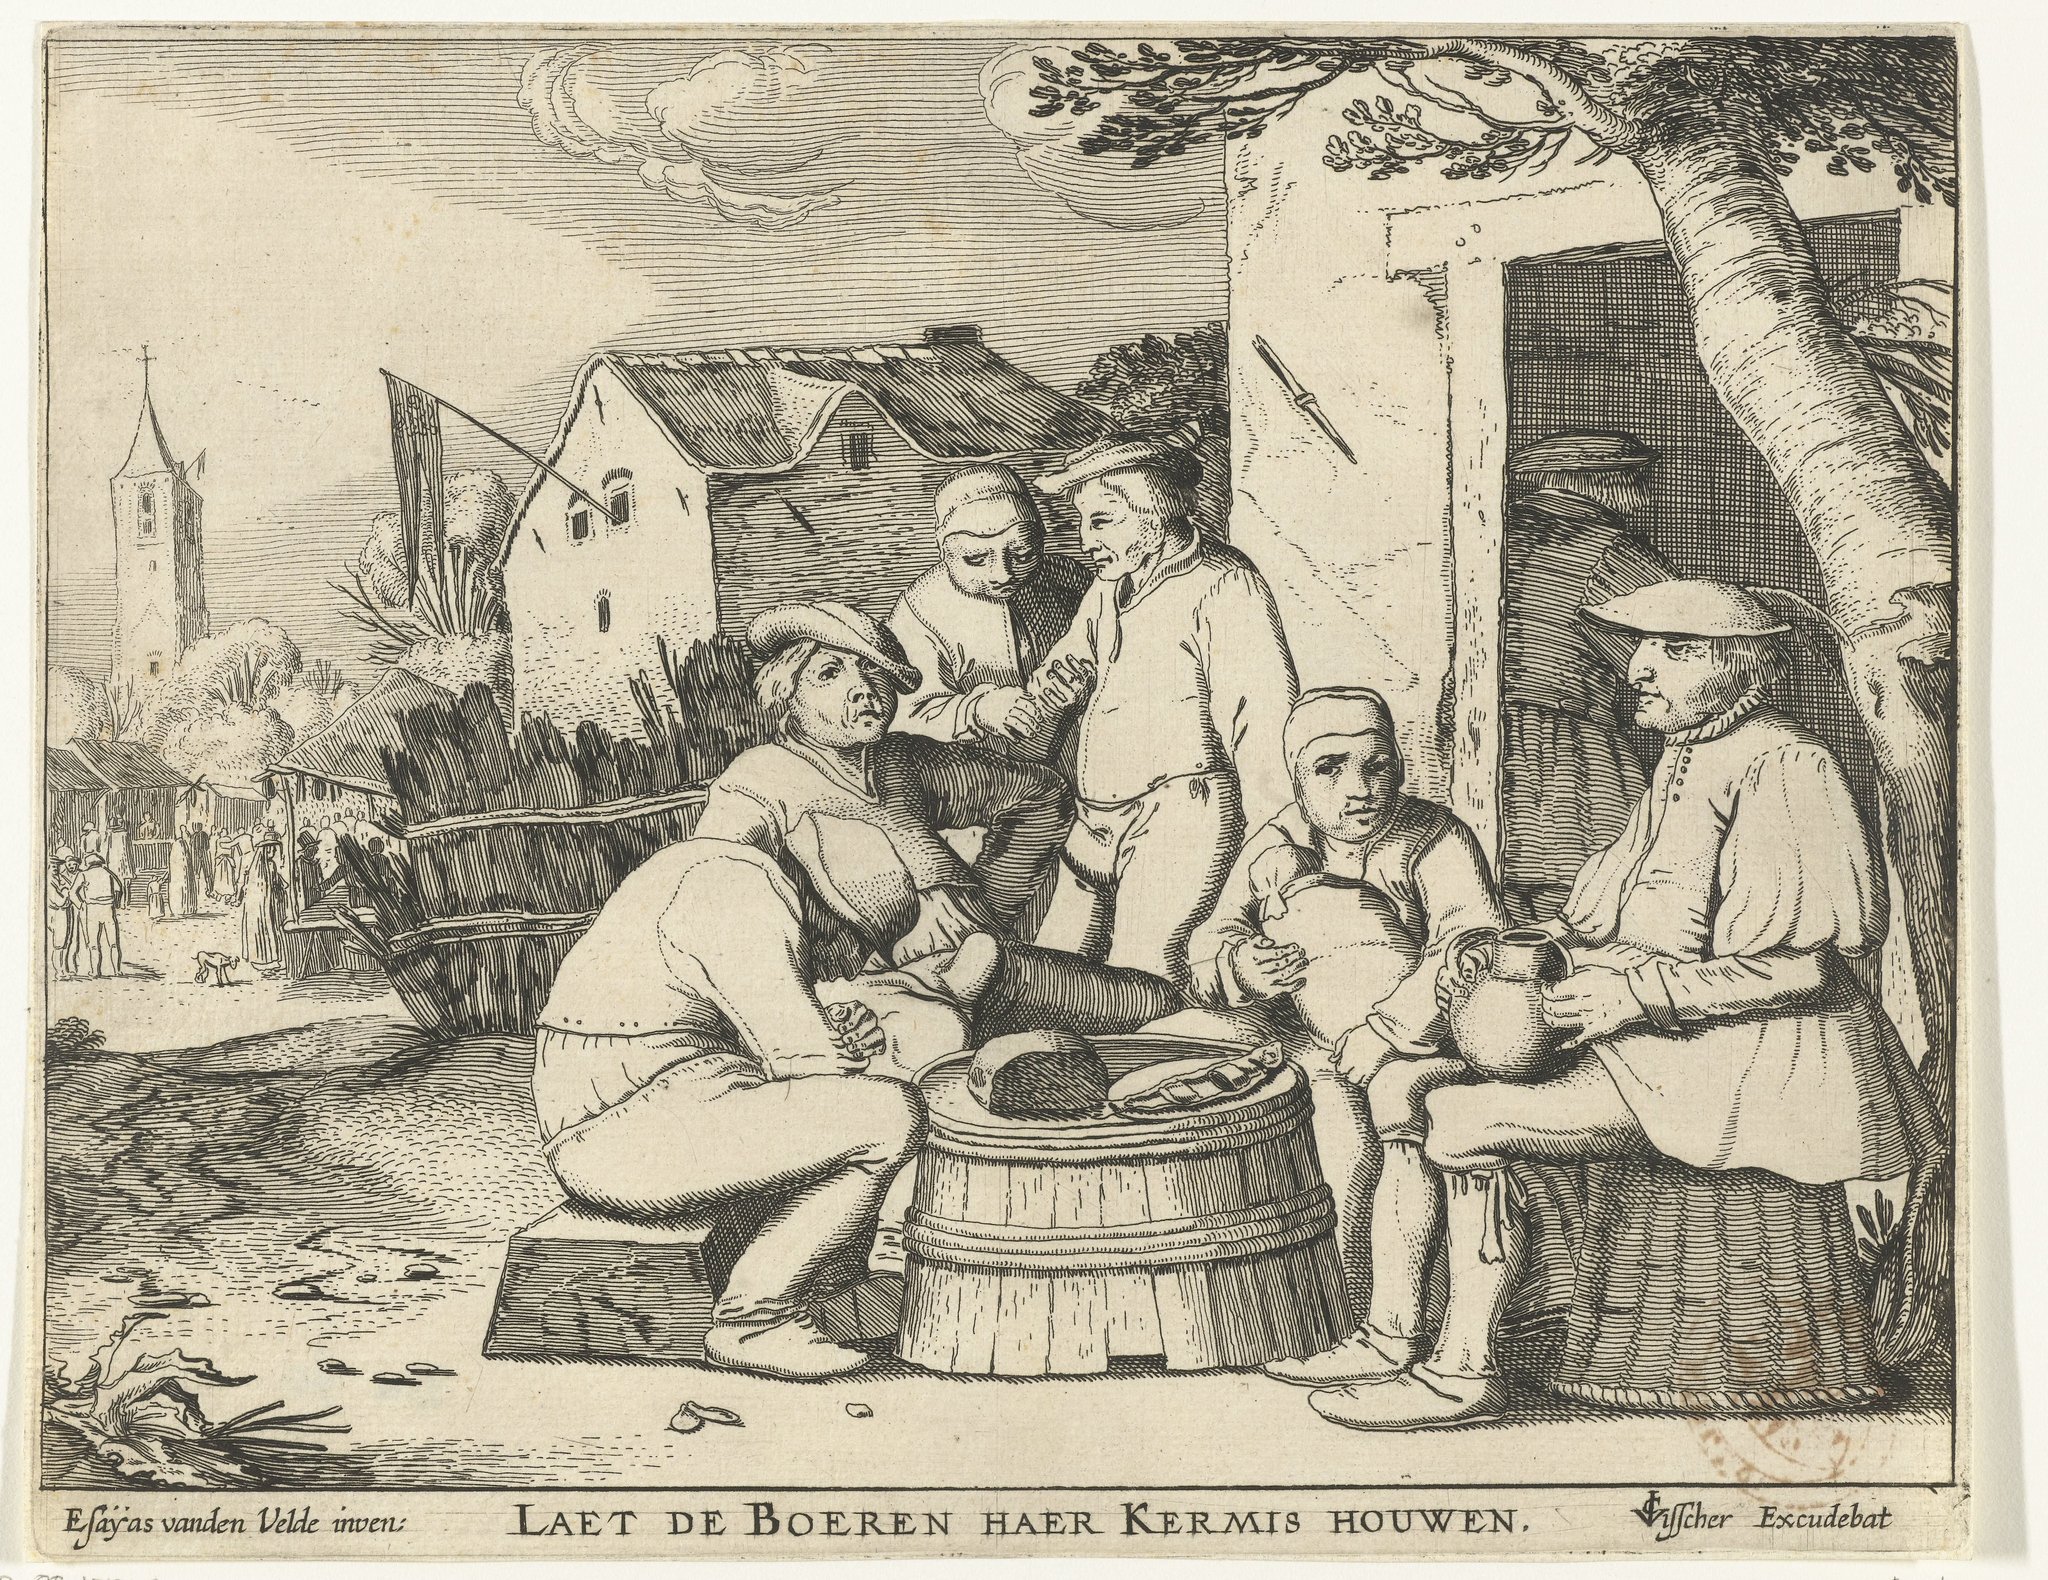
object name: print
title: Zes boeren zittend rond een ton bij een herberg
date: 1613-1680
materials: paper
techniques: engraving, etching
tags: inn, coffee-house, public house, etc., farmers, drinking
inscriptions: collector's mark: Lugt 240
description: Dorpsstraat met boeren bij een herberg. Ze zitten aan een karige maaltijd met een brood en een vis op een halve ton. Dit is bedriegelijk want een van de boeren heeft een grote kruik met drank op zijn schoot en een andere heeft al zoveel gedronken dat hij ondersteund wordt door een vrouw. Op de achtergrond is een boerenkermis gaande. Dit is een kopie in dezelfde richting als het origineel waar het motto Laet de boeren haer kermis houwen aan toegevoegd is.